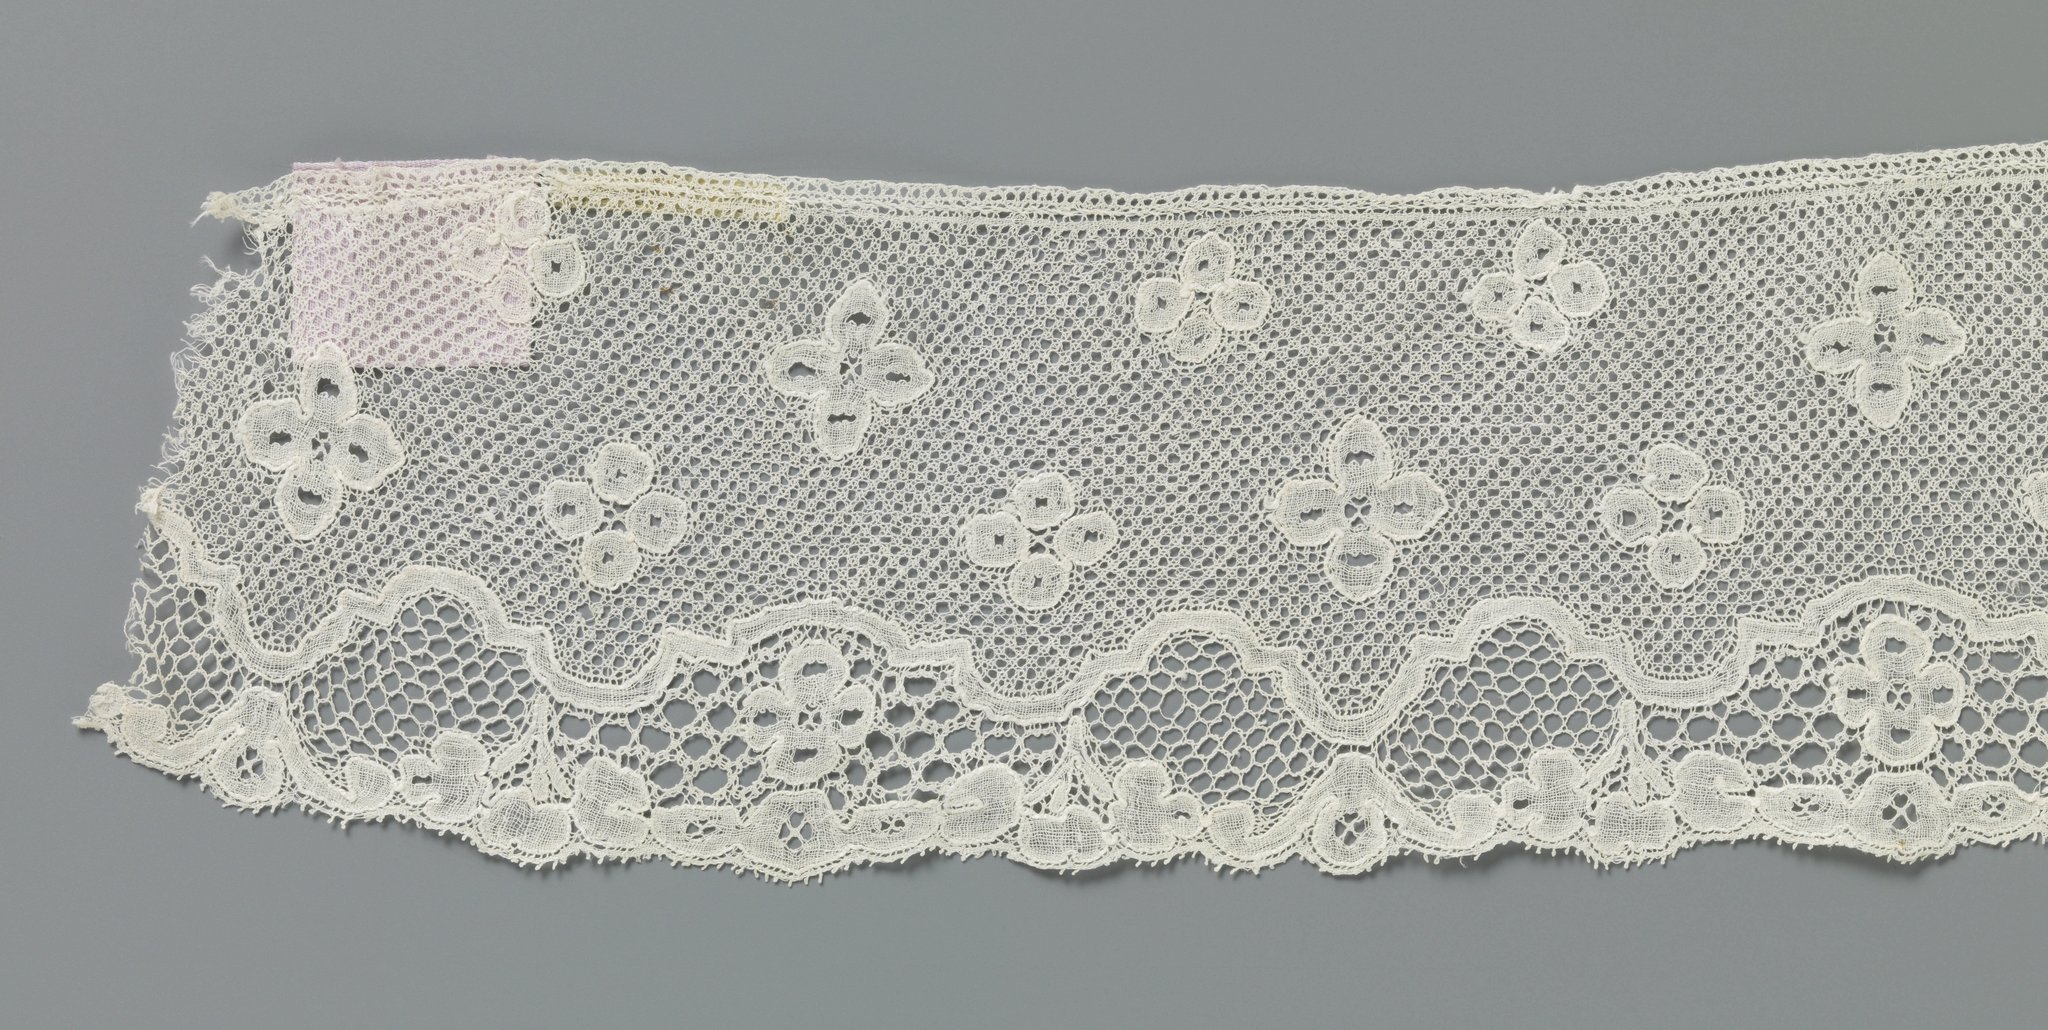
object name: strip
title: Strook kloskant met symmetrisch patroon rond doorlopende geschulpte sierlijst onder de middenlijn van de strook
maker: Anonymous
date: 1800-1849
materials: linen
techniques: lace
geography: mechelen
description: Strook naturelkleurige kloskant, Vlaanderse kant. Het patroon op de bovenste helft van de strook bestaat uit twee rijen losse motieven, steeds twee keer een configuratie van vier rondjes, afgewisseld door een bloem met vier spitsovale bloembladeren. Ruim onder de middenlijn van de strook bestaat het zich herhalende en symmetrische patroon uit een doorlopende geschulpte sierlijst, die met de aaneengeschakelde gestileerde blaadjes en bloempjes langs de onderzijde van de strook een soort cartouches vormt. Om de twee cartouches staat een losse rozetbloem. De motieven zijn boven de sierlijst met elkaar verbonden door een traliegrond, een vijfgaatjesgrond. Onder de sierlijst zijn siergronden toegepast. De motieven zijn gemaakt in linnenslag met uitsparingen en dikkere en glimmende contourdraden. De bovenzijde van de strook is afgewerkt met een apart geklost bandje. De schulpenrand langs de onderzijde van de strook is afgewerkt met picots.